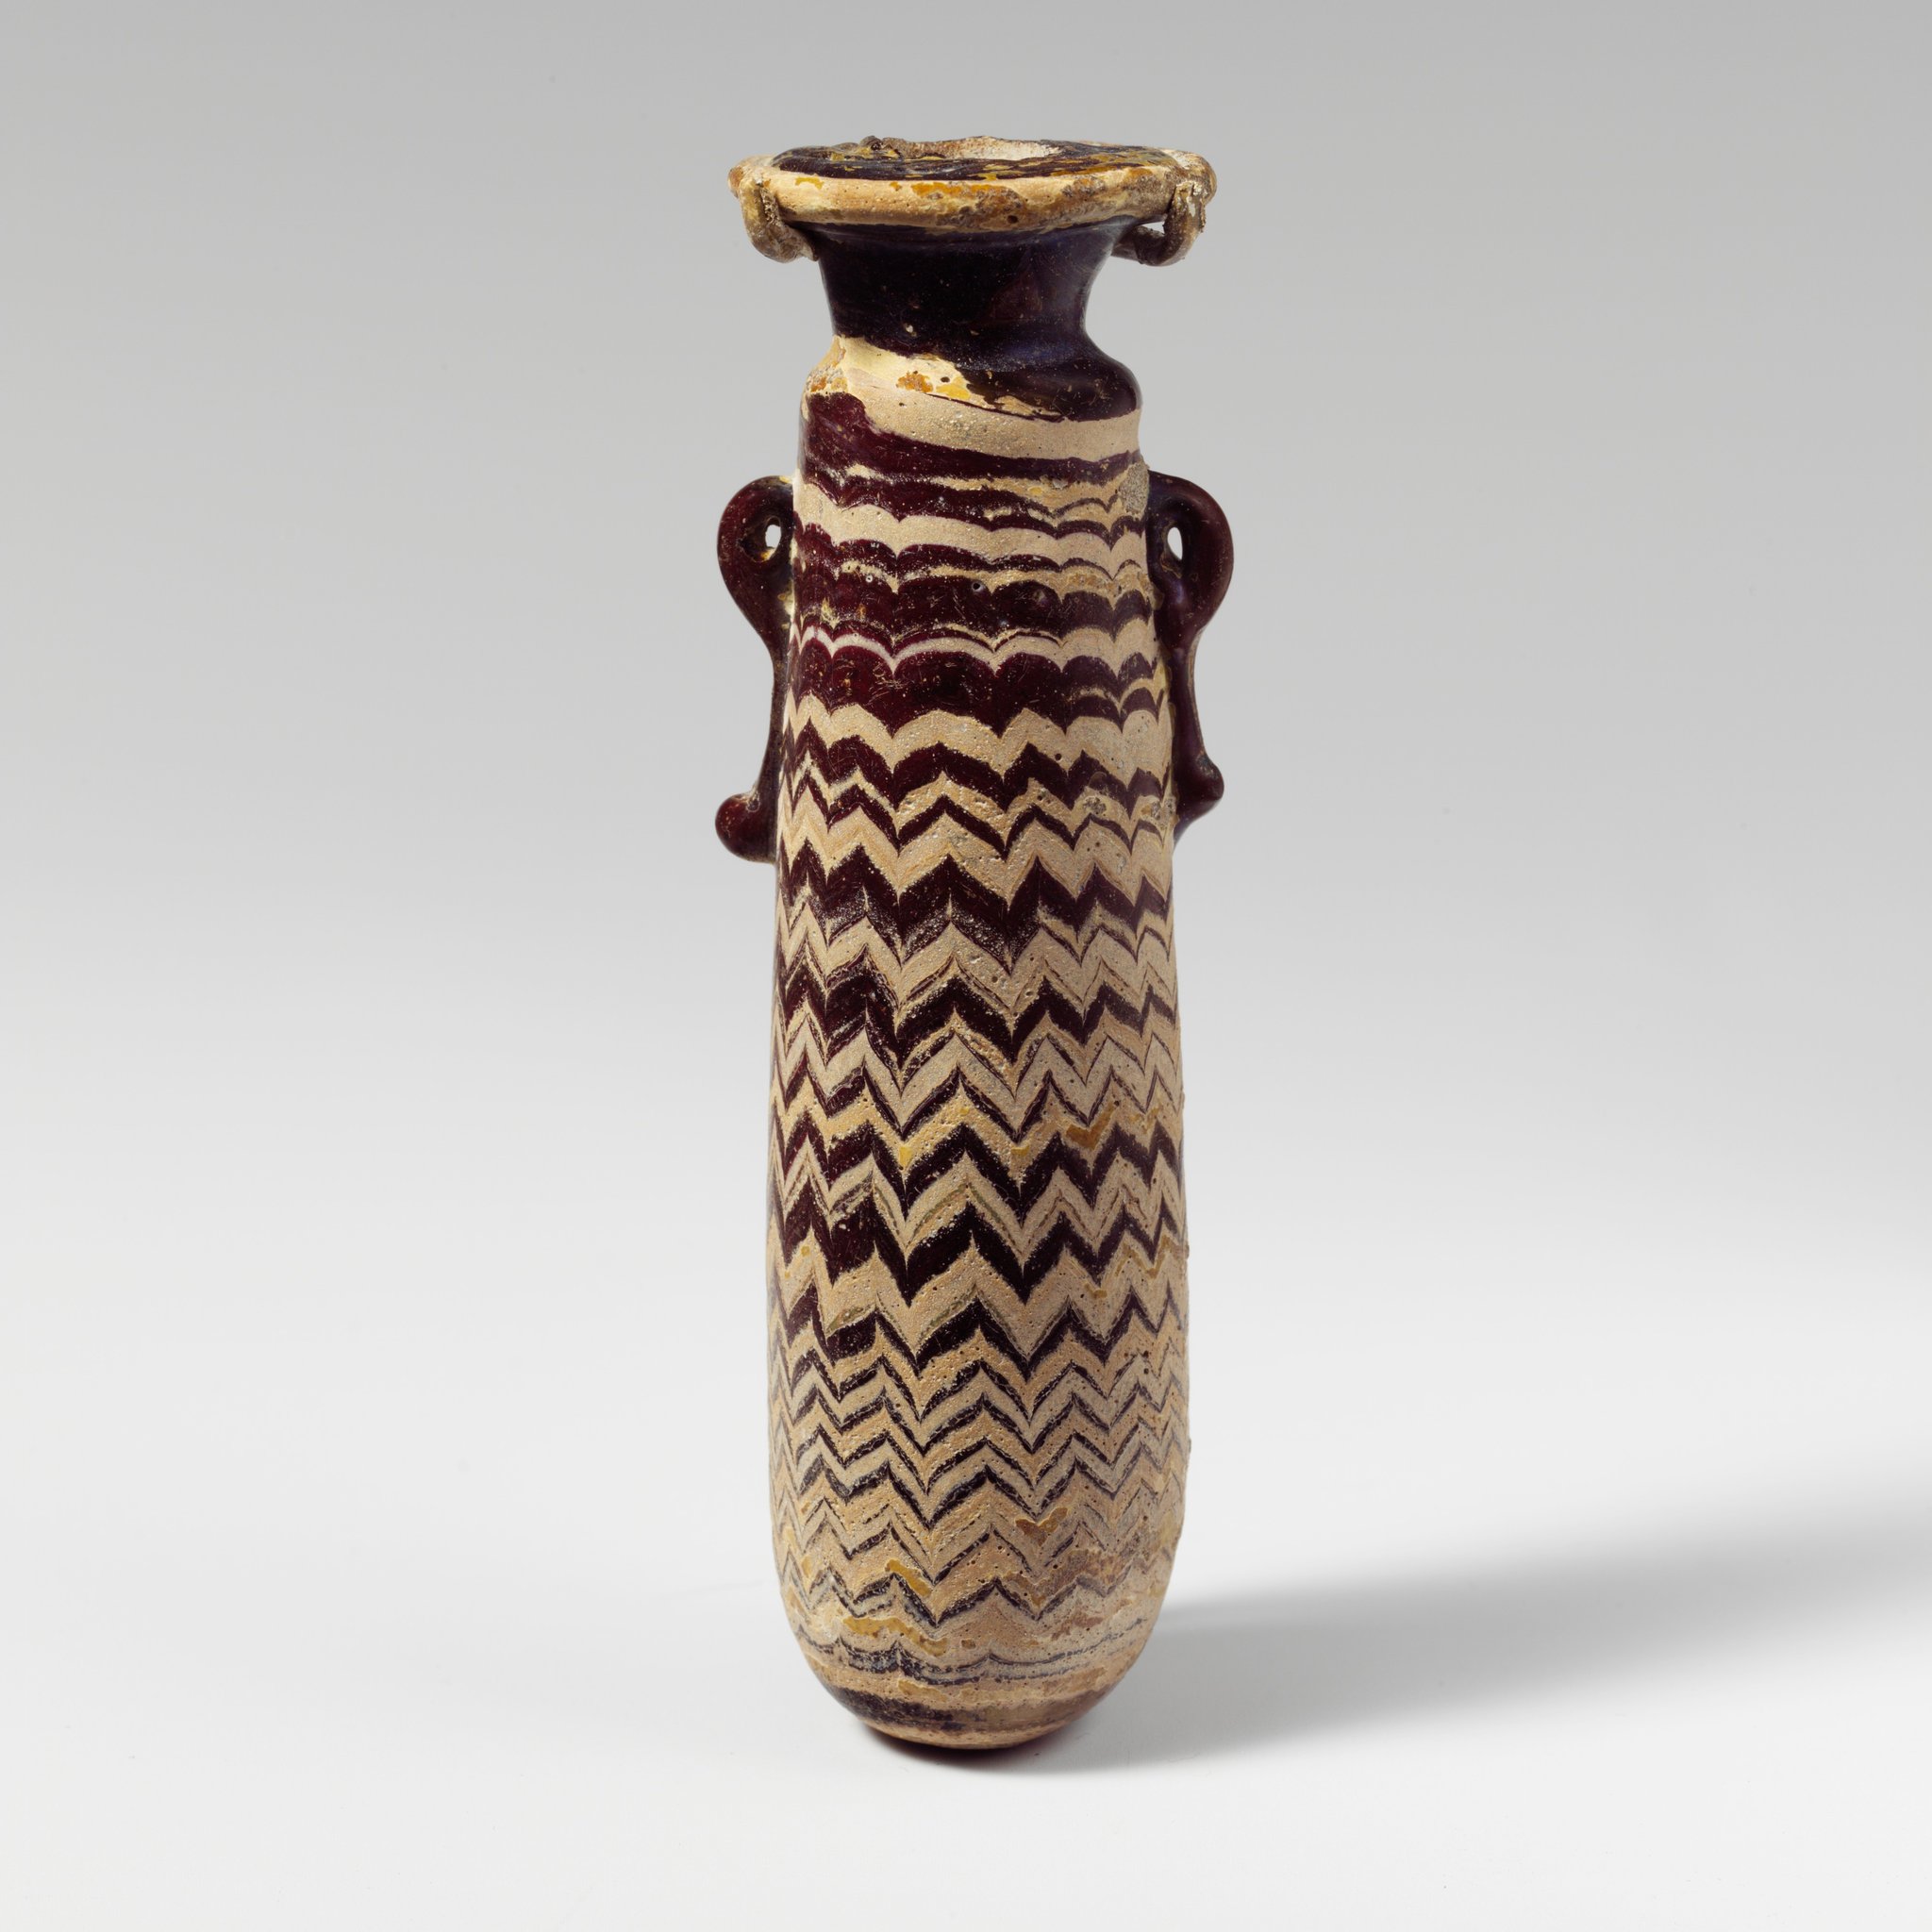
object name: alabastron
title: Glass alabastron (perfume bottle)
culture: greek, eastern mediterranean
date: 534-401 BCE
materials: glass